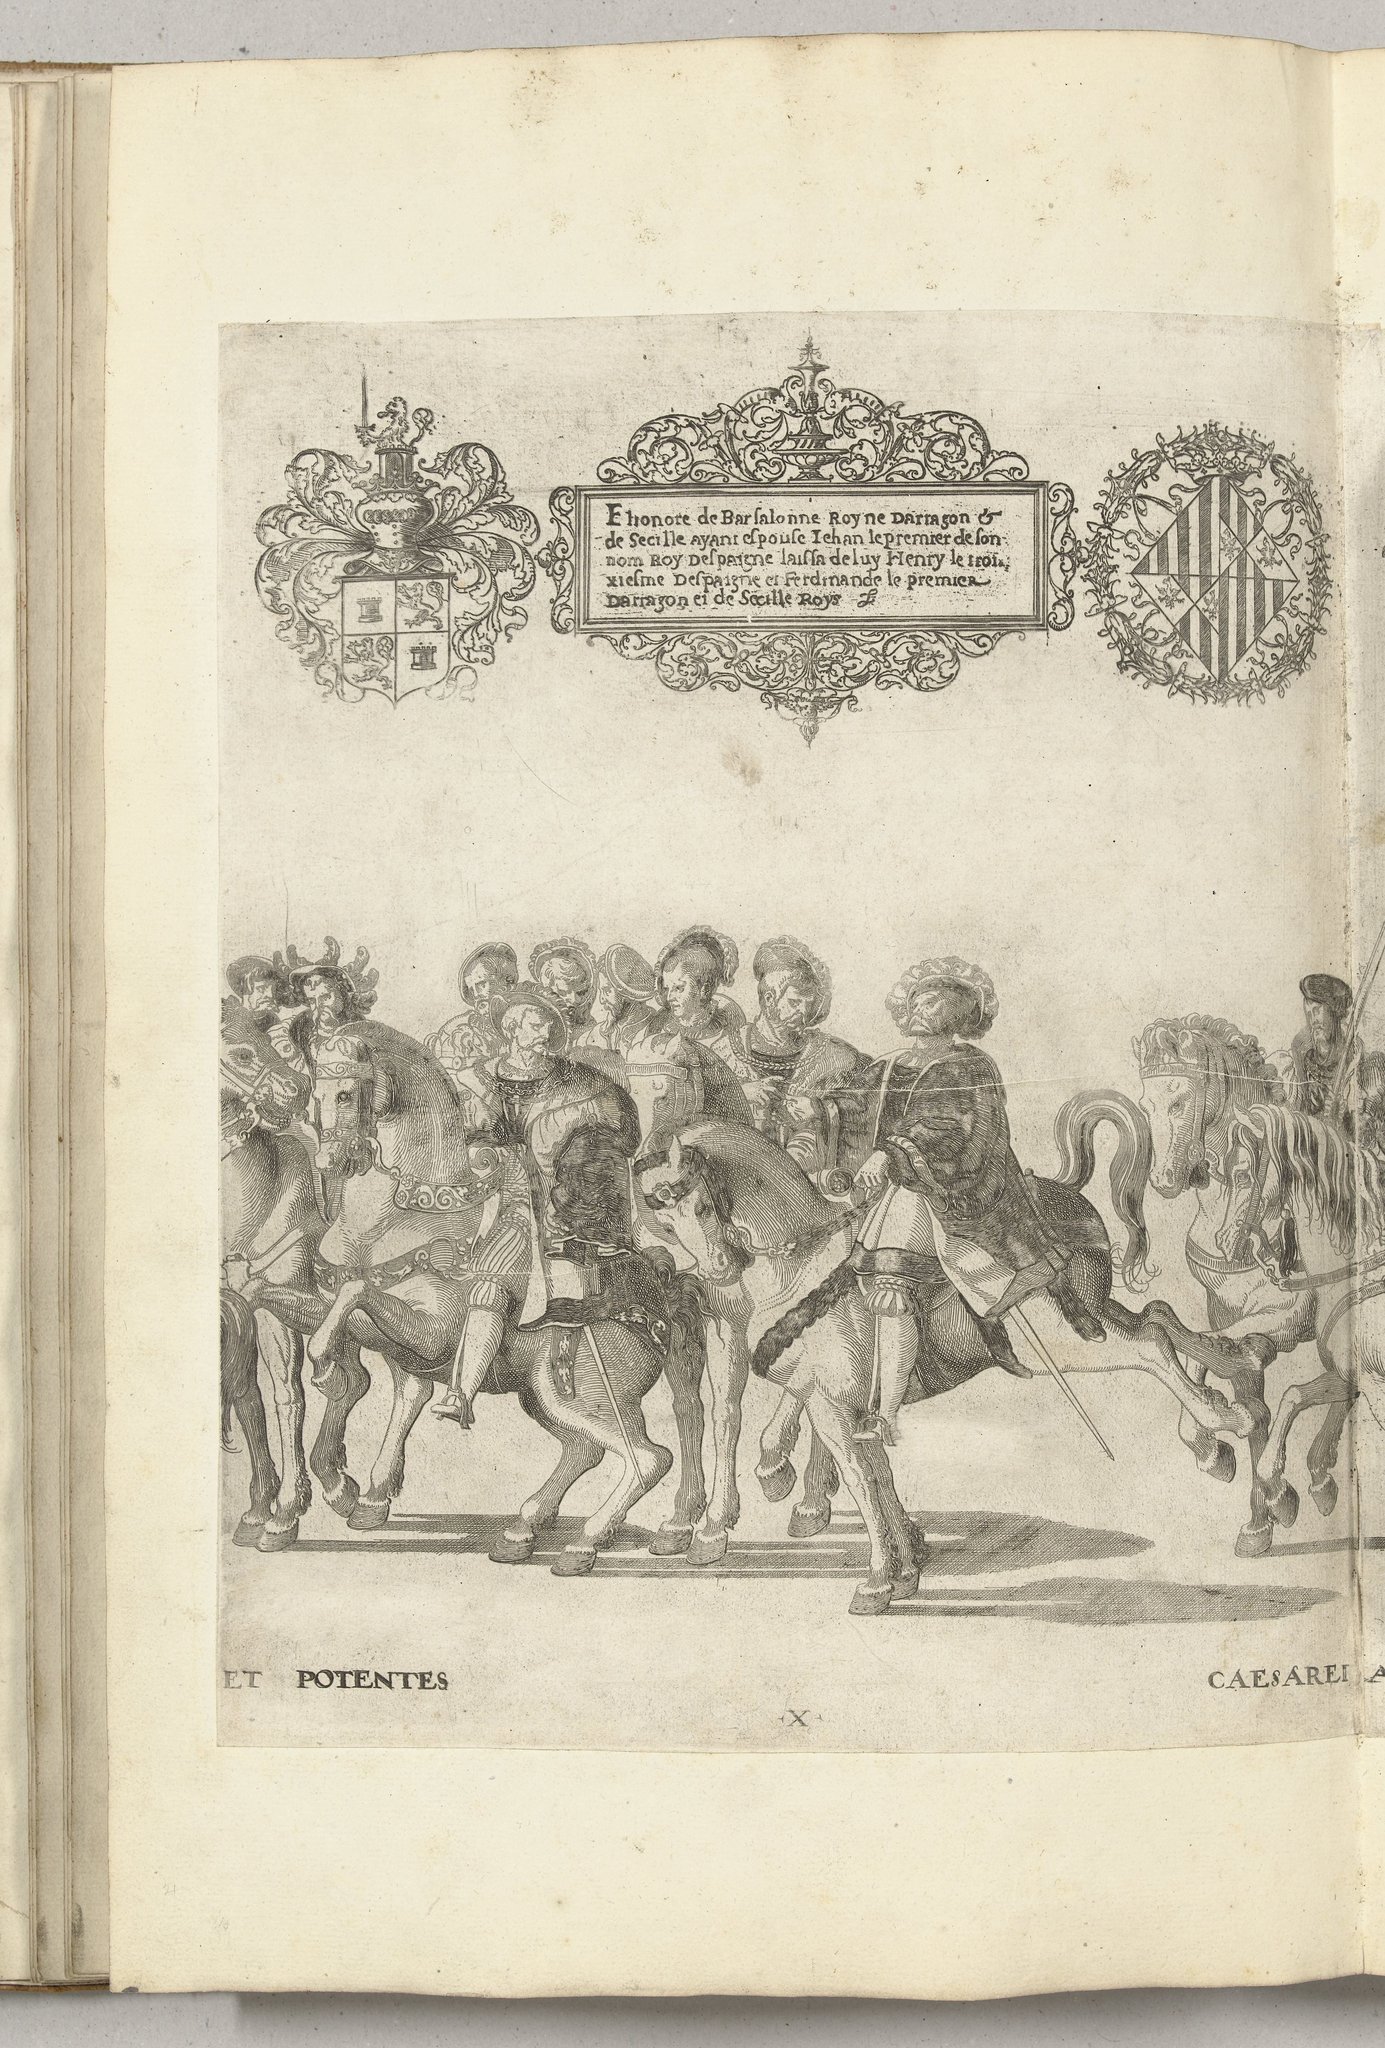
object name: propagandaprent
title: Optocht van Karel V met de paus te Bologna na zijn kroning to keizer, 1530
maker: nicolaas hogenberg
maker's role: draughtsman, painter, print maker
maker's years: 1500-1539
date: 1530-1536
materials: paper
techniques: etching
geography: mechelen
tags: charles v (holy roman emperor and king of spain), festivities (+ parade, pageant, cavalcade ~ festive activities)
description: Prent in het album waarin zijn ingeplakt de 40 platen die achterelkaar samen het fries vormen van de optocht van Karel V met de paus Clemens VII te Bologna na zijn kroning tot keizer, 24 februari 1530.